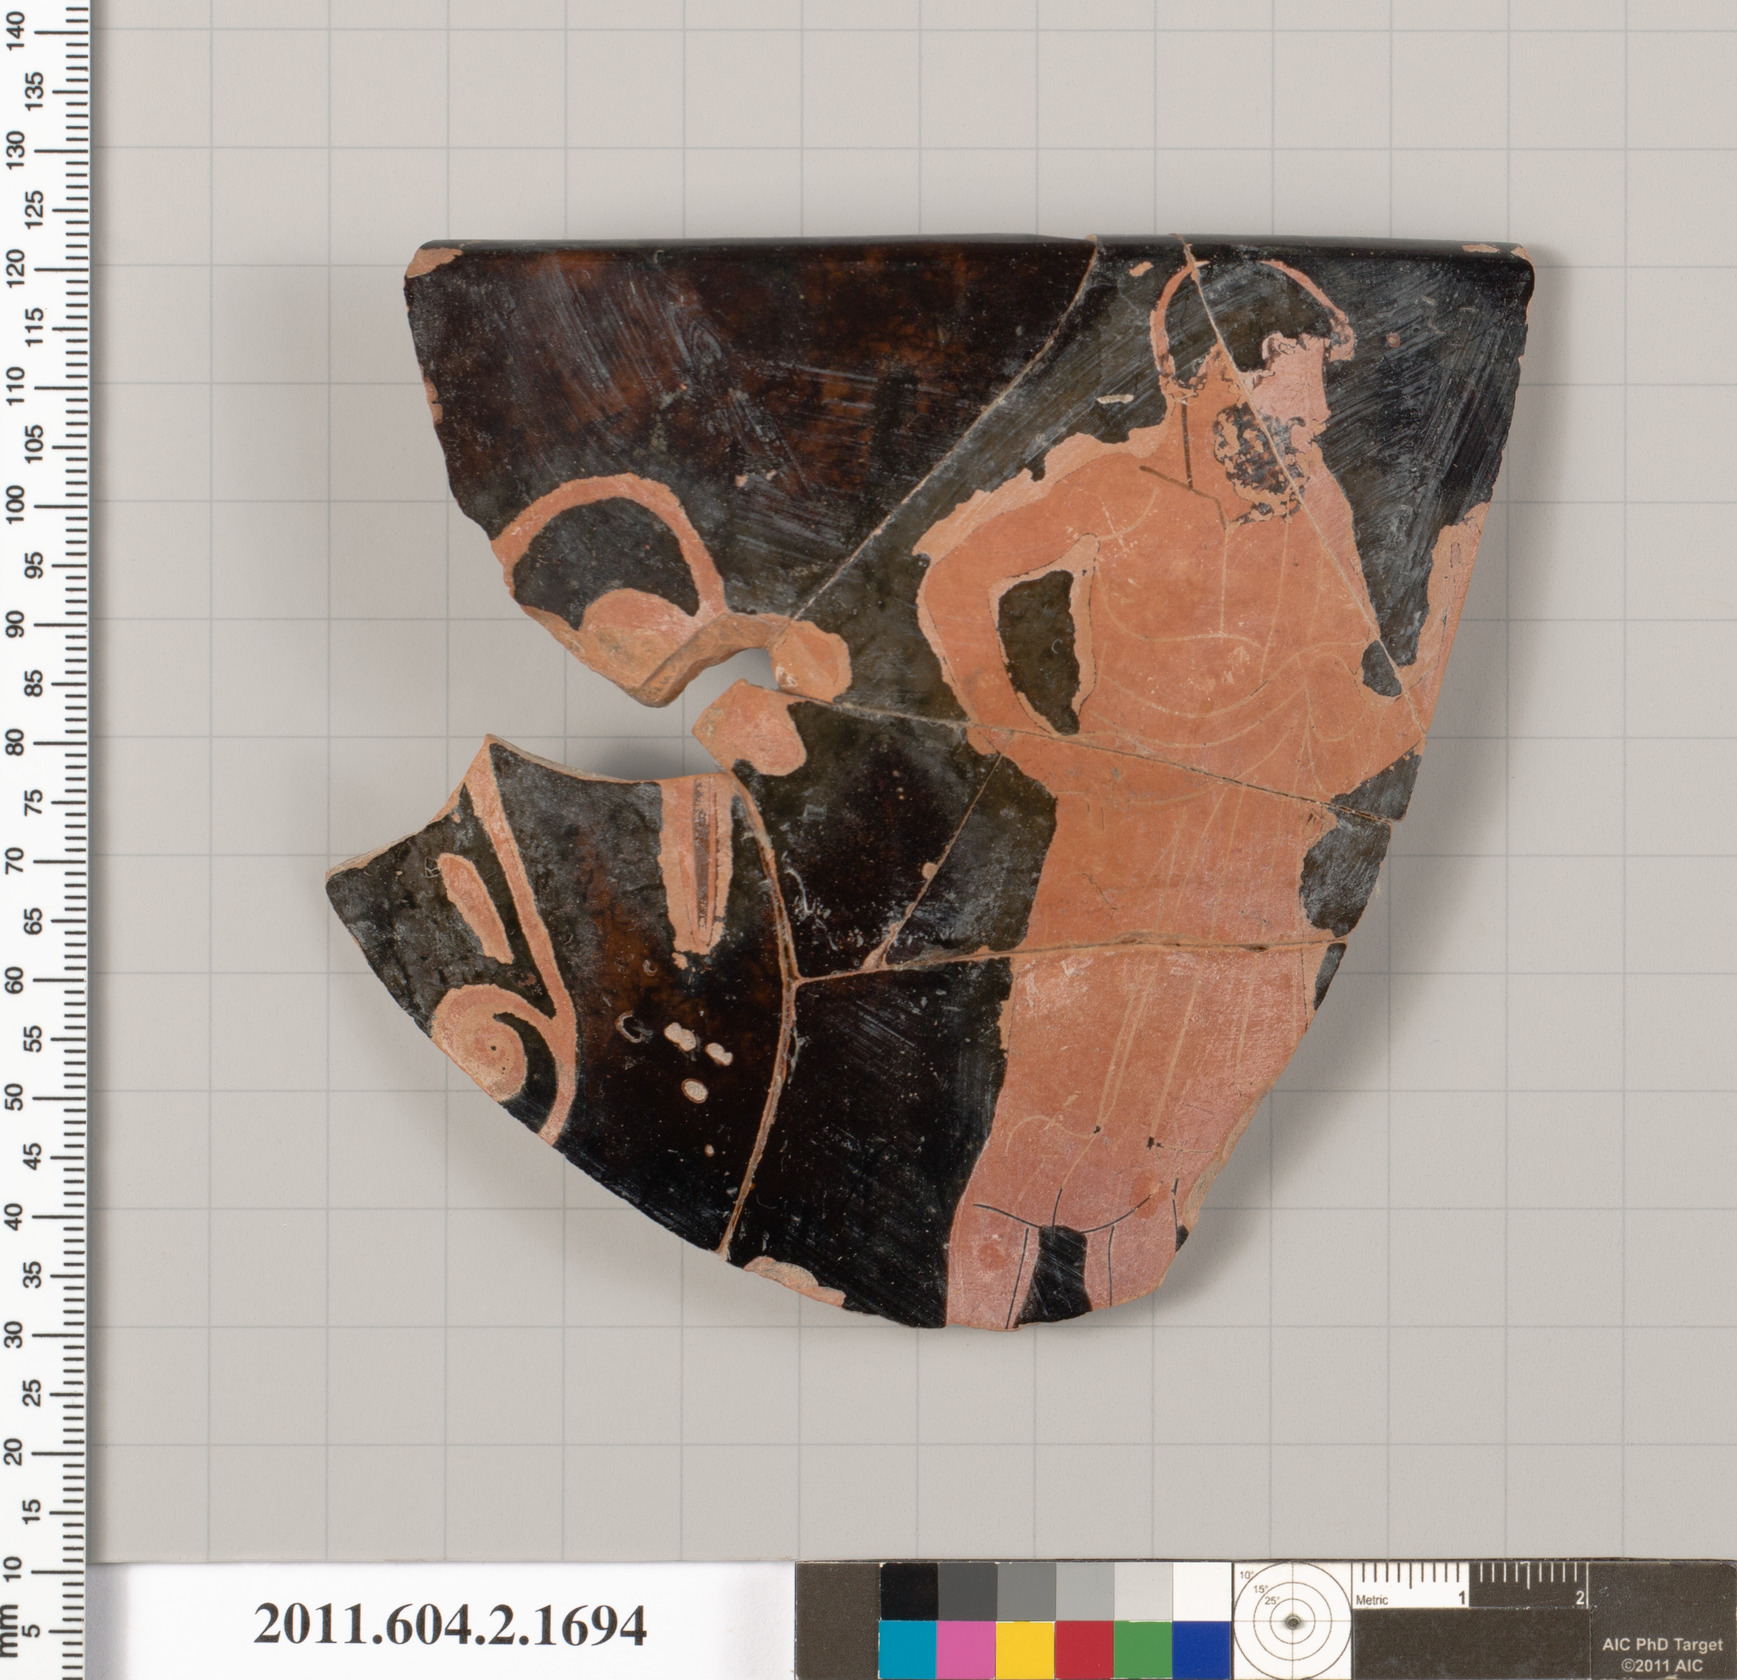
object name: skyphos fragment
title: Terracotta fragment of a skyphos (deep drinking cup)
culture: greek, attic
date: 440-420 BCE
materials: terracotta